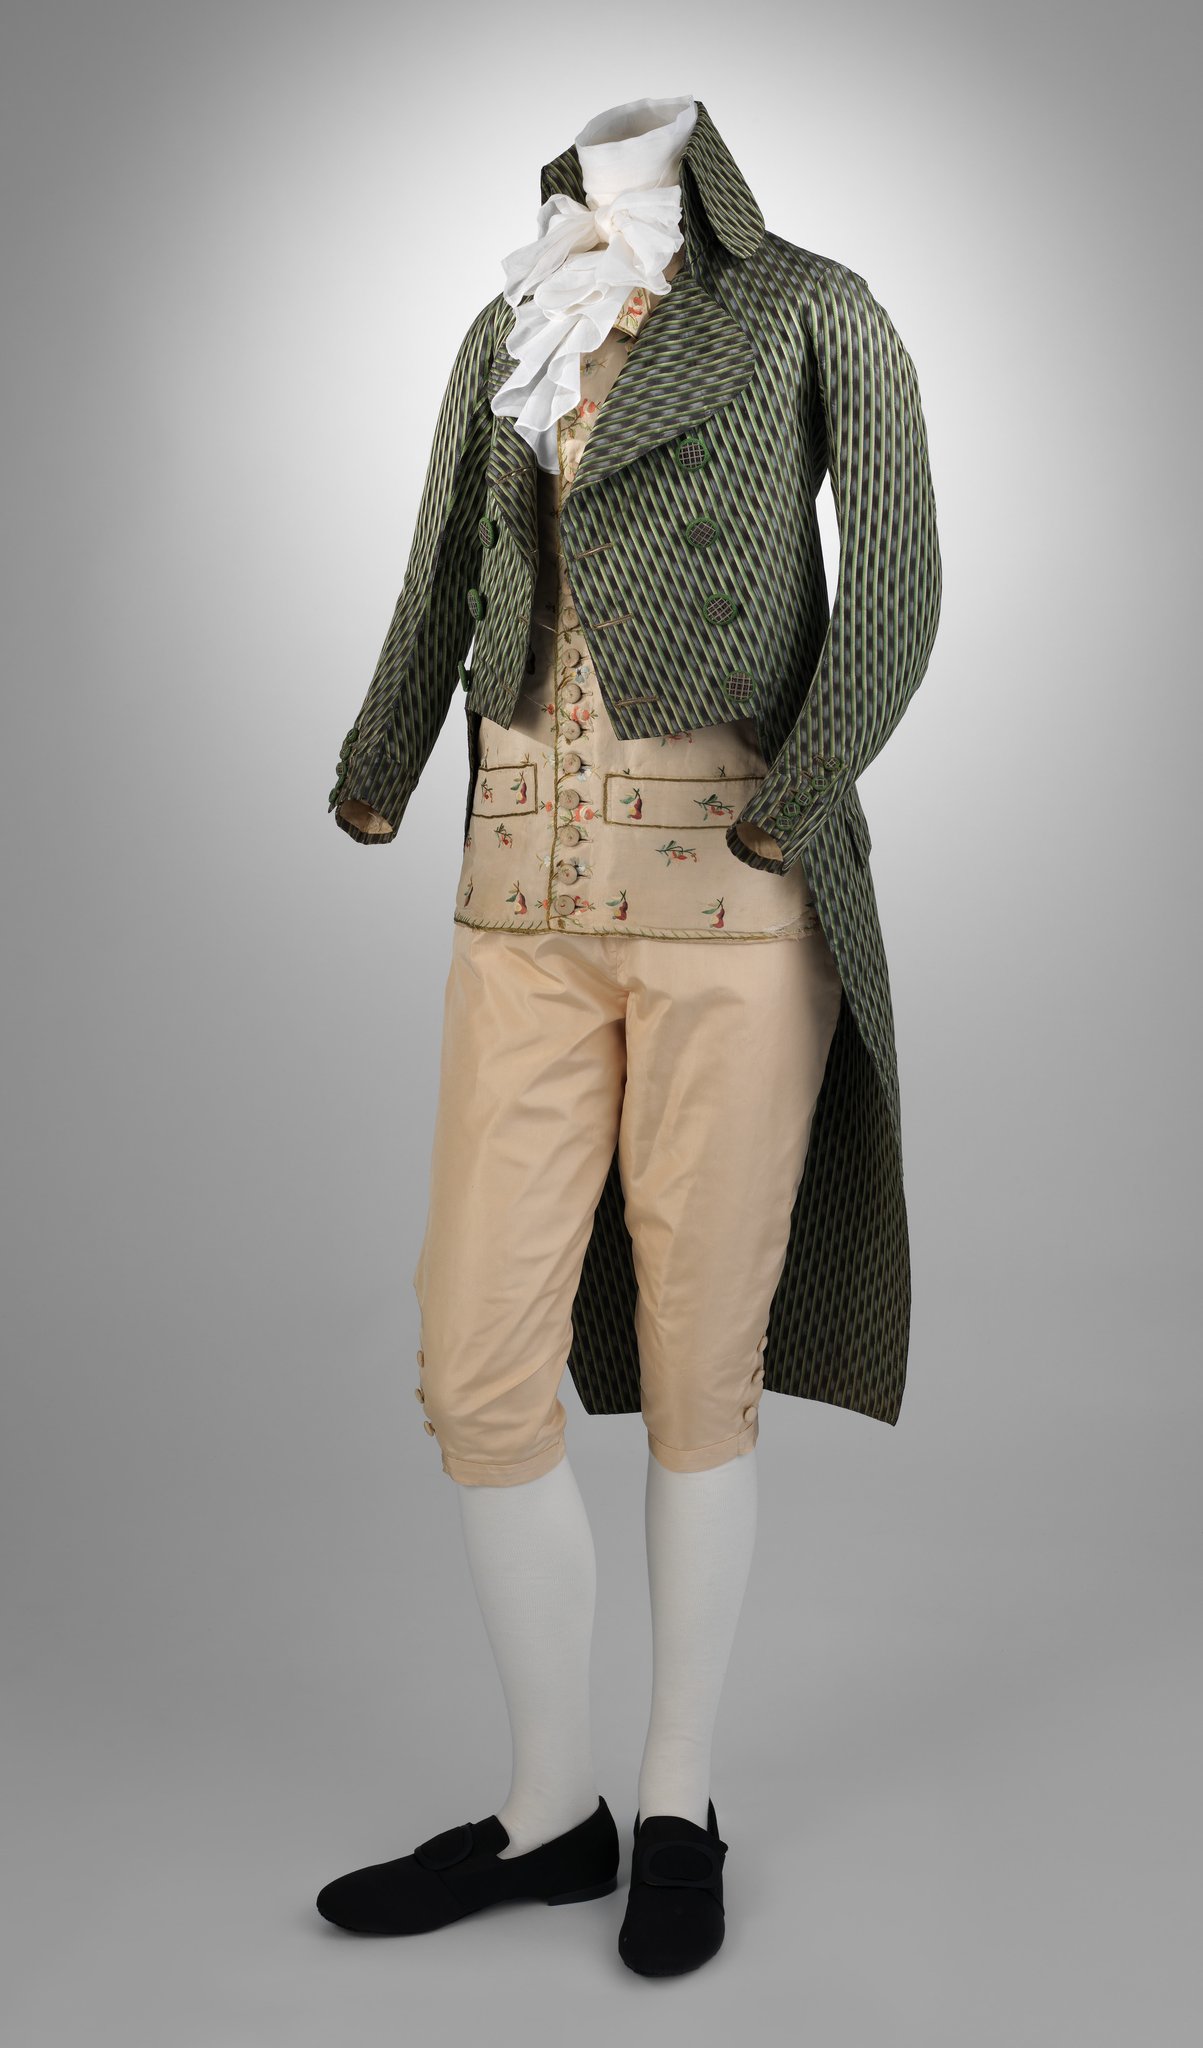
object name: coat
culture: french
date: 1790-1799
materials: silk